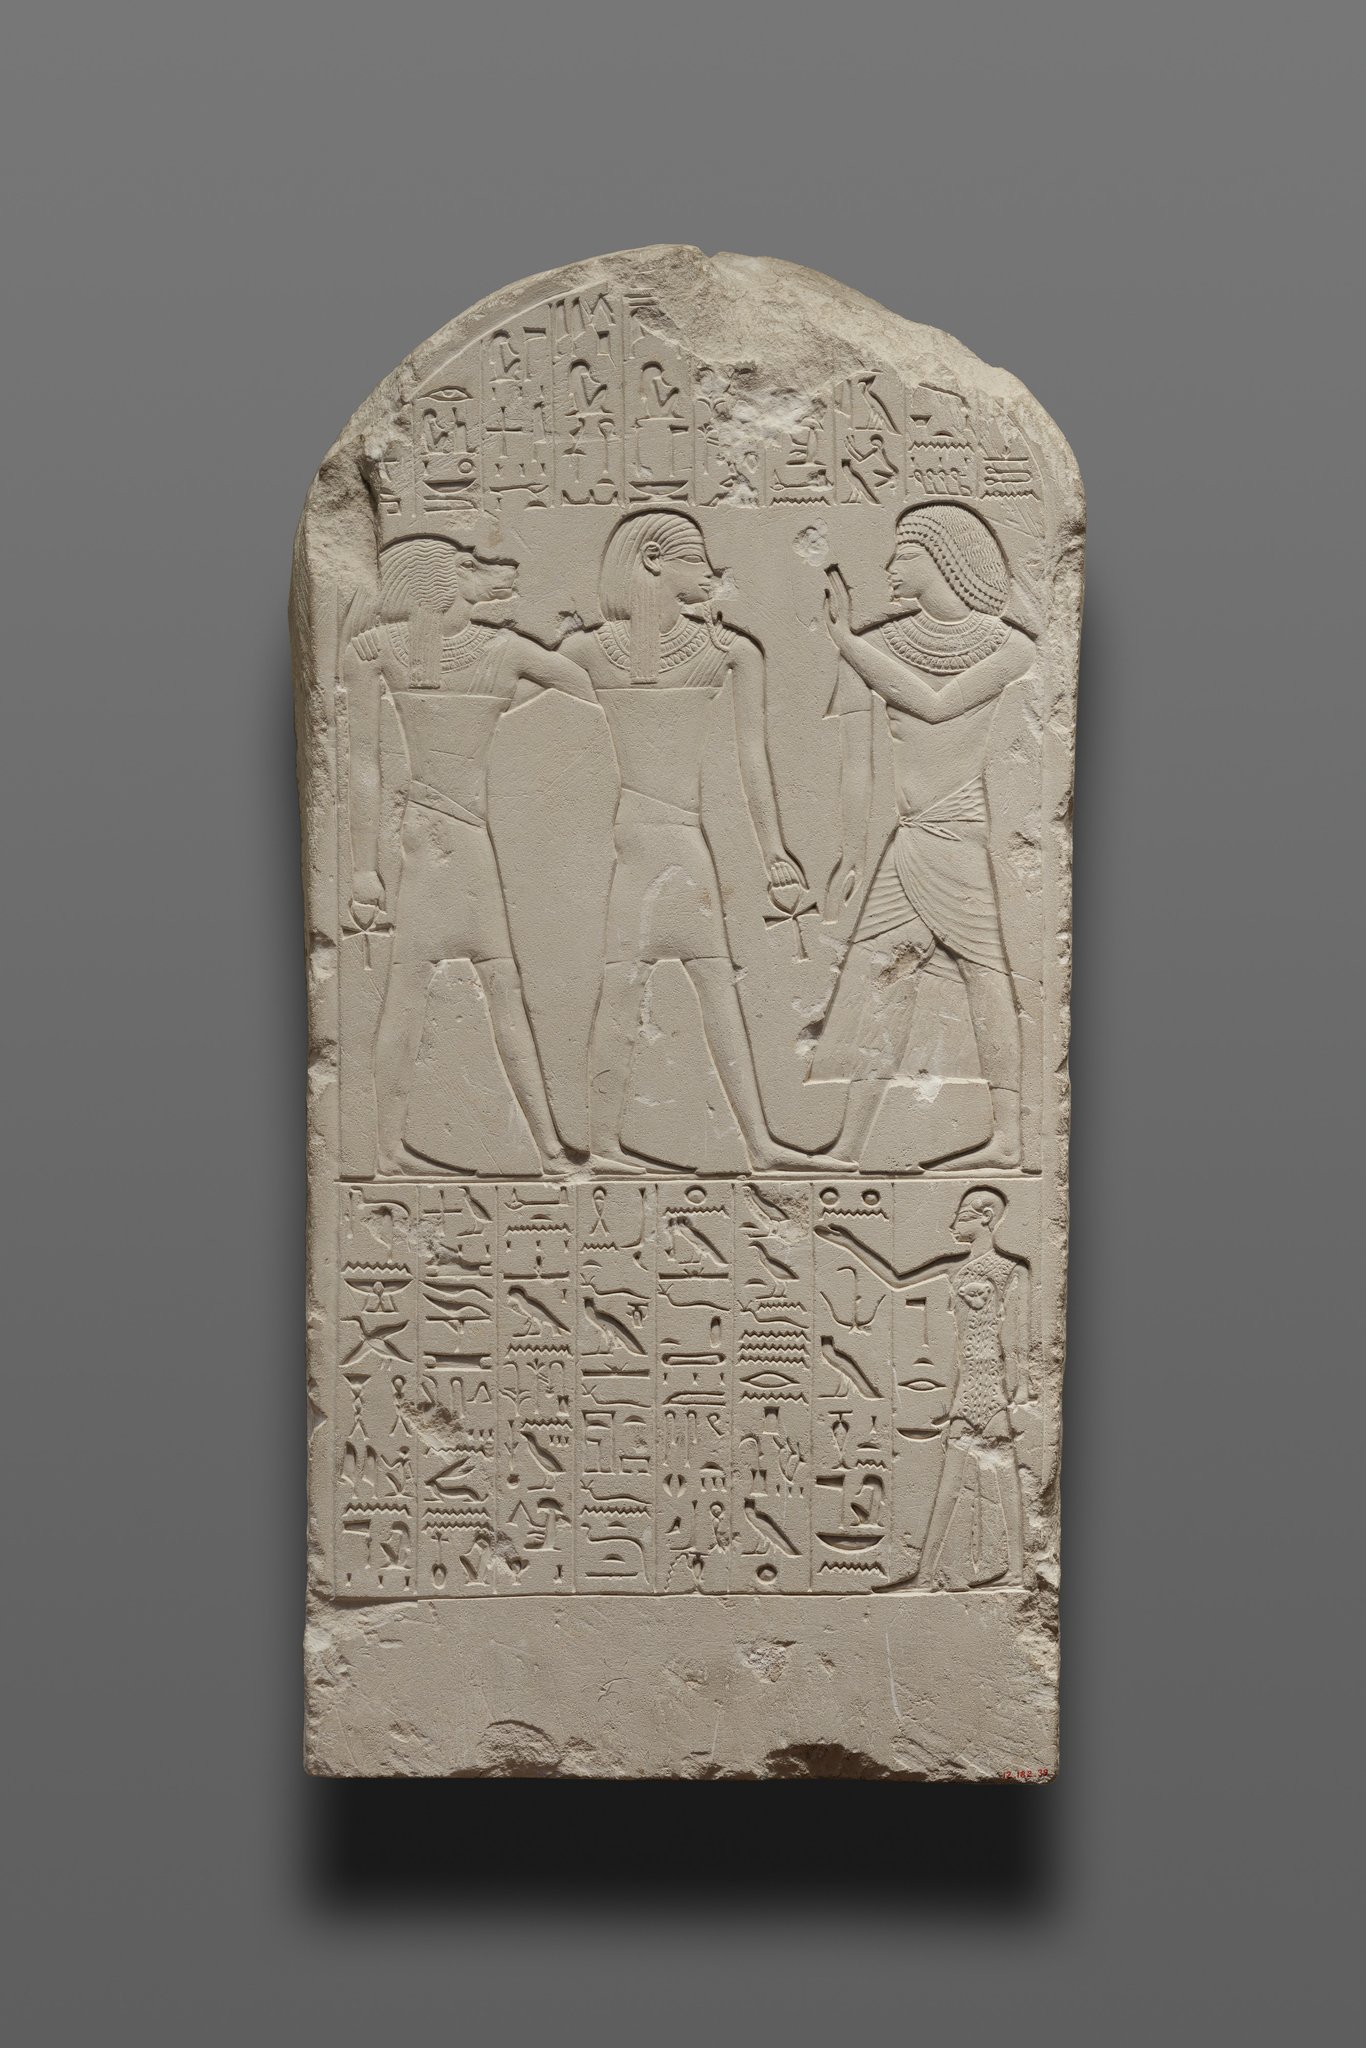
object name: stela, senu, imseti, hapy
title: Stela of Senu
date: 1390-1352 BCE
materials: limestone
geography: middle egypt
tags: men,hieroglyphs